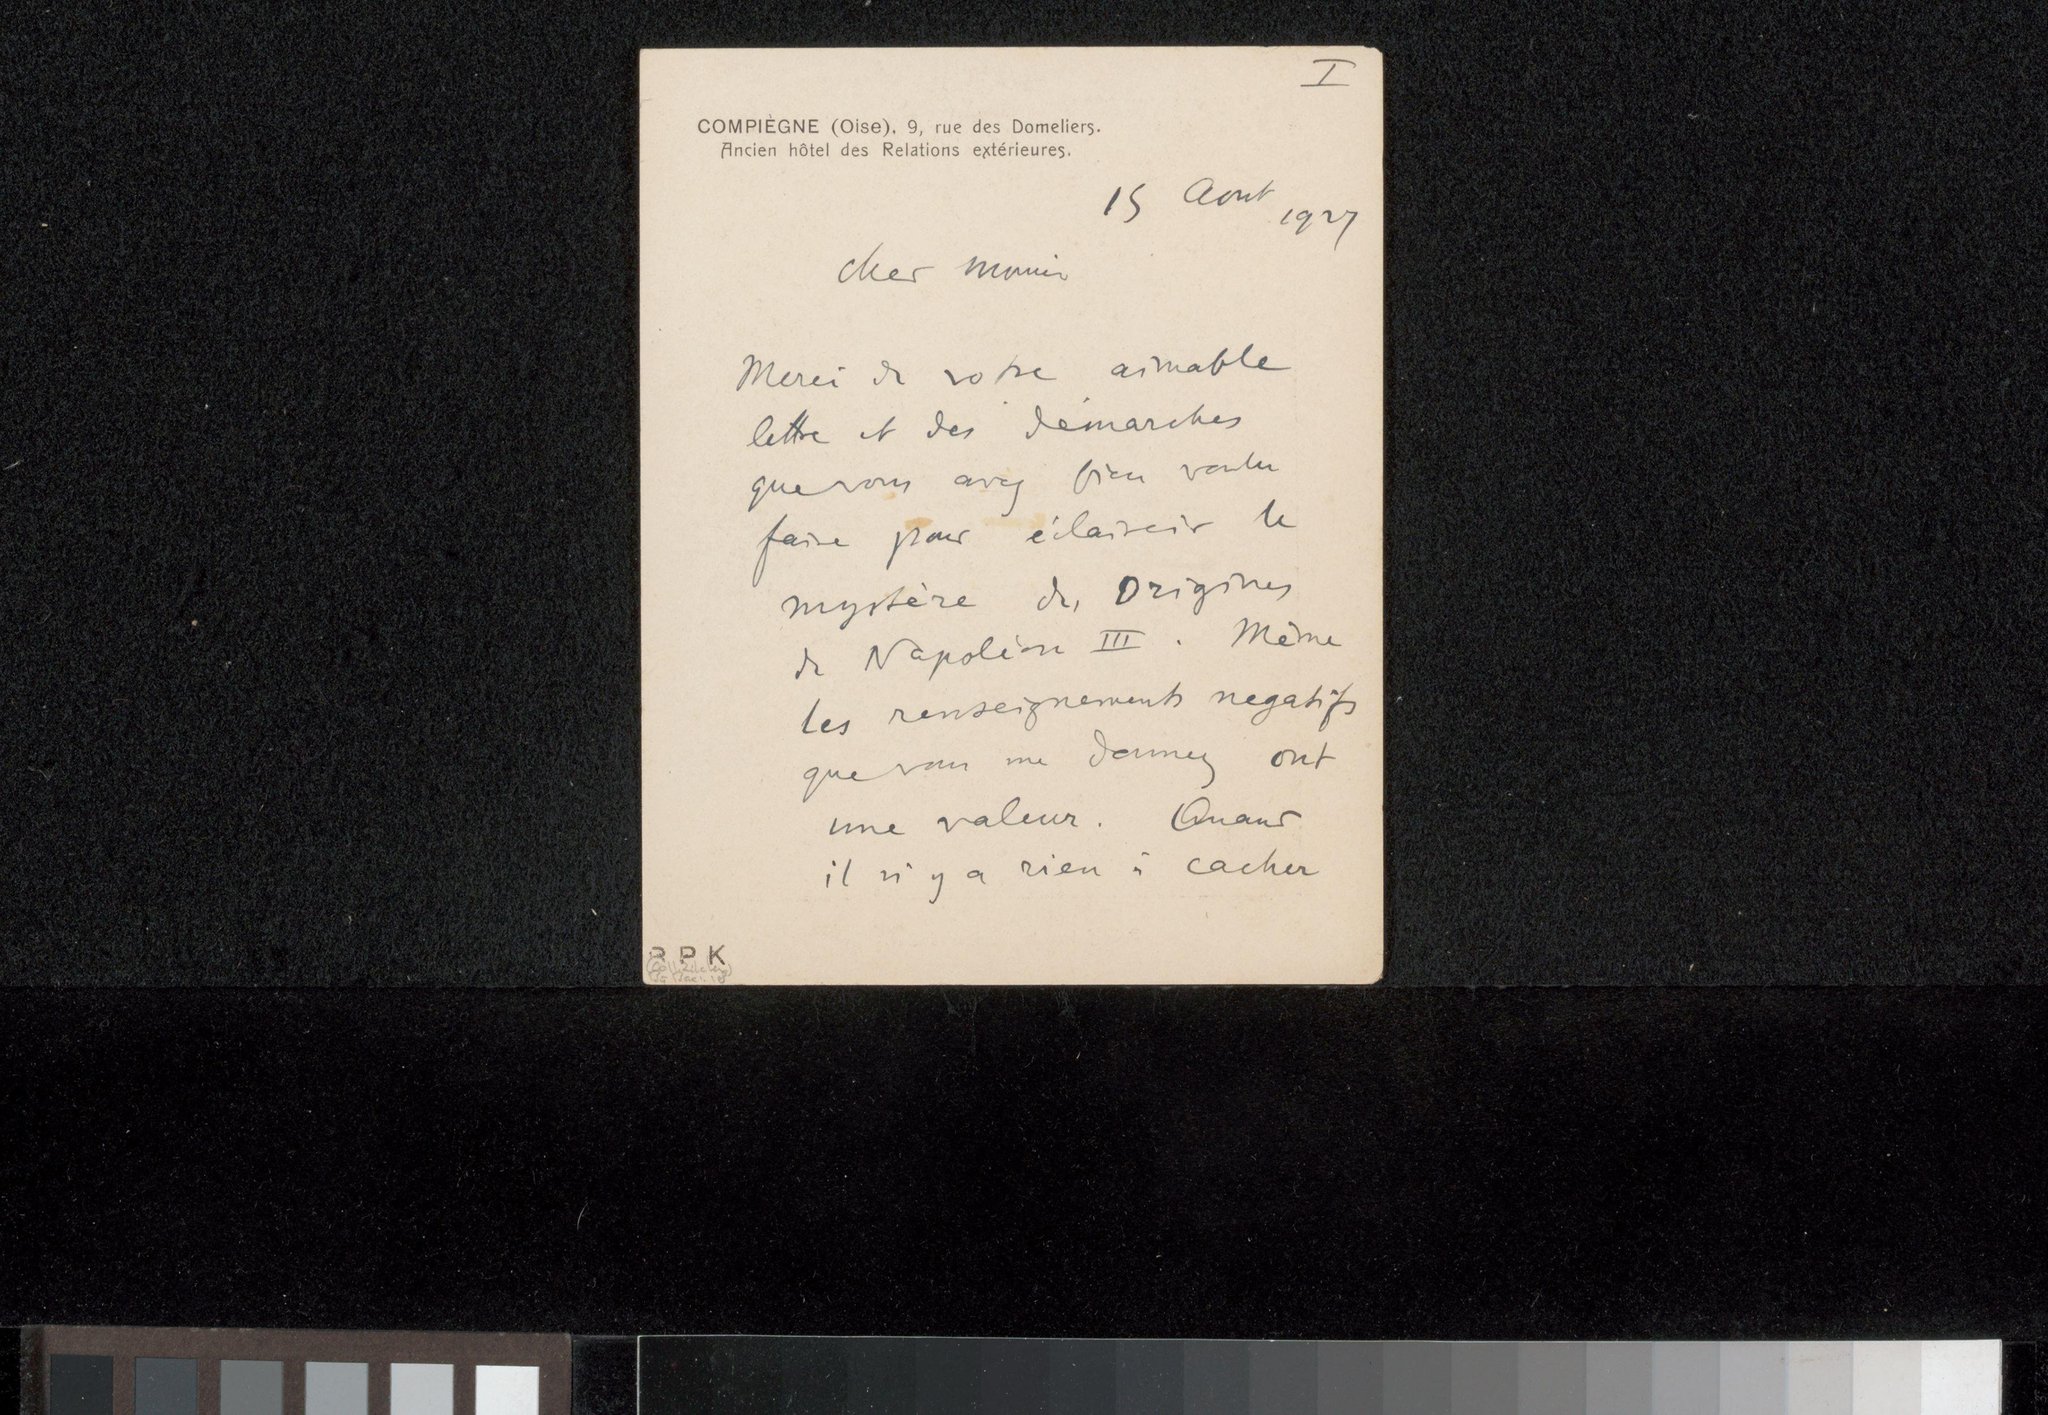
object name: ansichtkaart, prentbriefkaart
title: Prentbriefkaarten aan Philip Zilcken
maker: ferdinand-sigismund bac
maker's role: draughtsman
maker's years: 1859-1952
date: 1927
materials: cardboard, ink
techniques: pen, printing, writing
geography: compiègne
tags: london, napoleon iii (keizer der fransen), the hague, draughtsman, philip zilcken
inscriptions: collector's mark: ‘RPK’